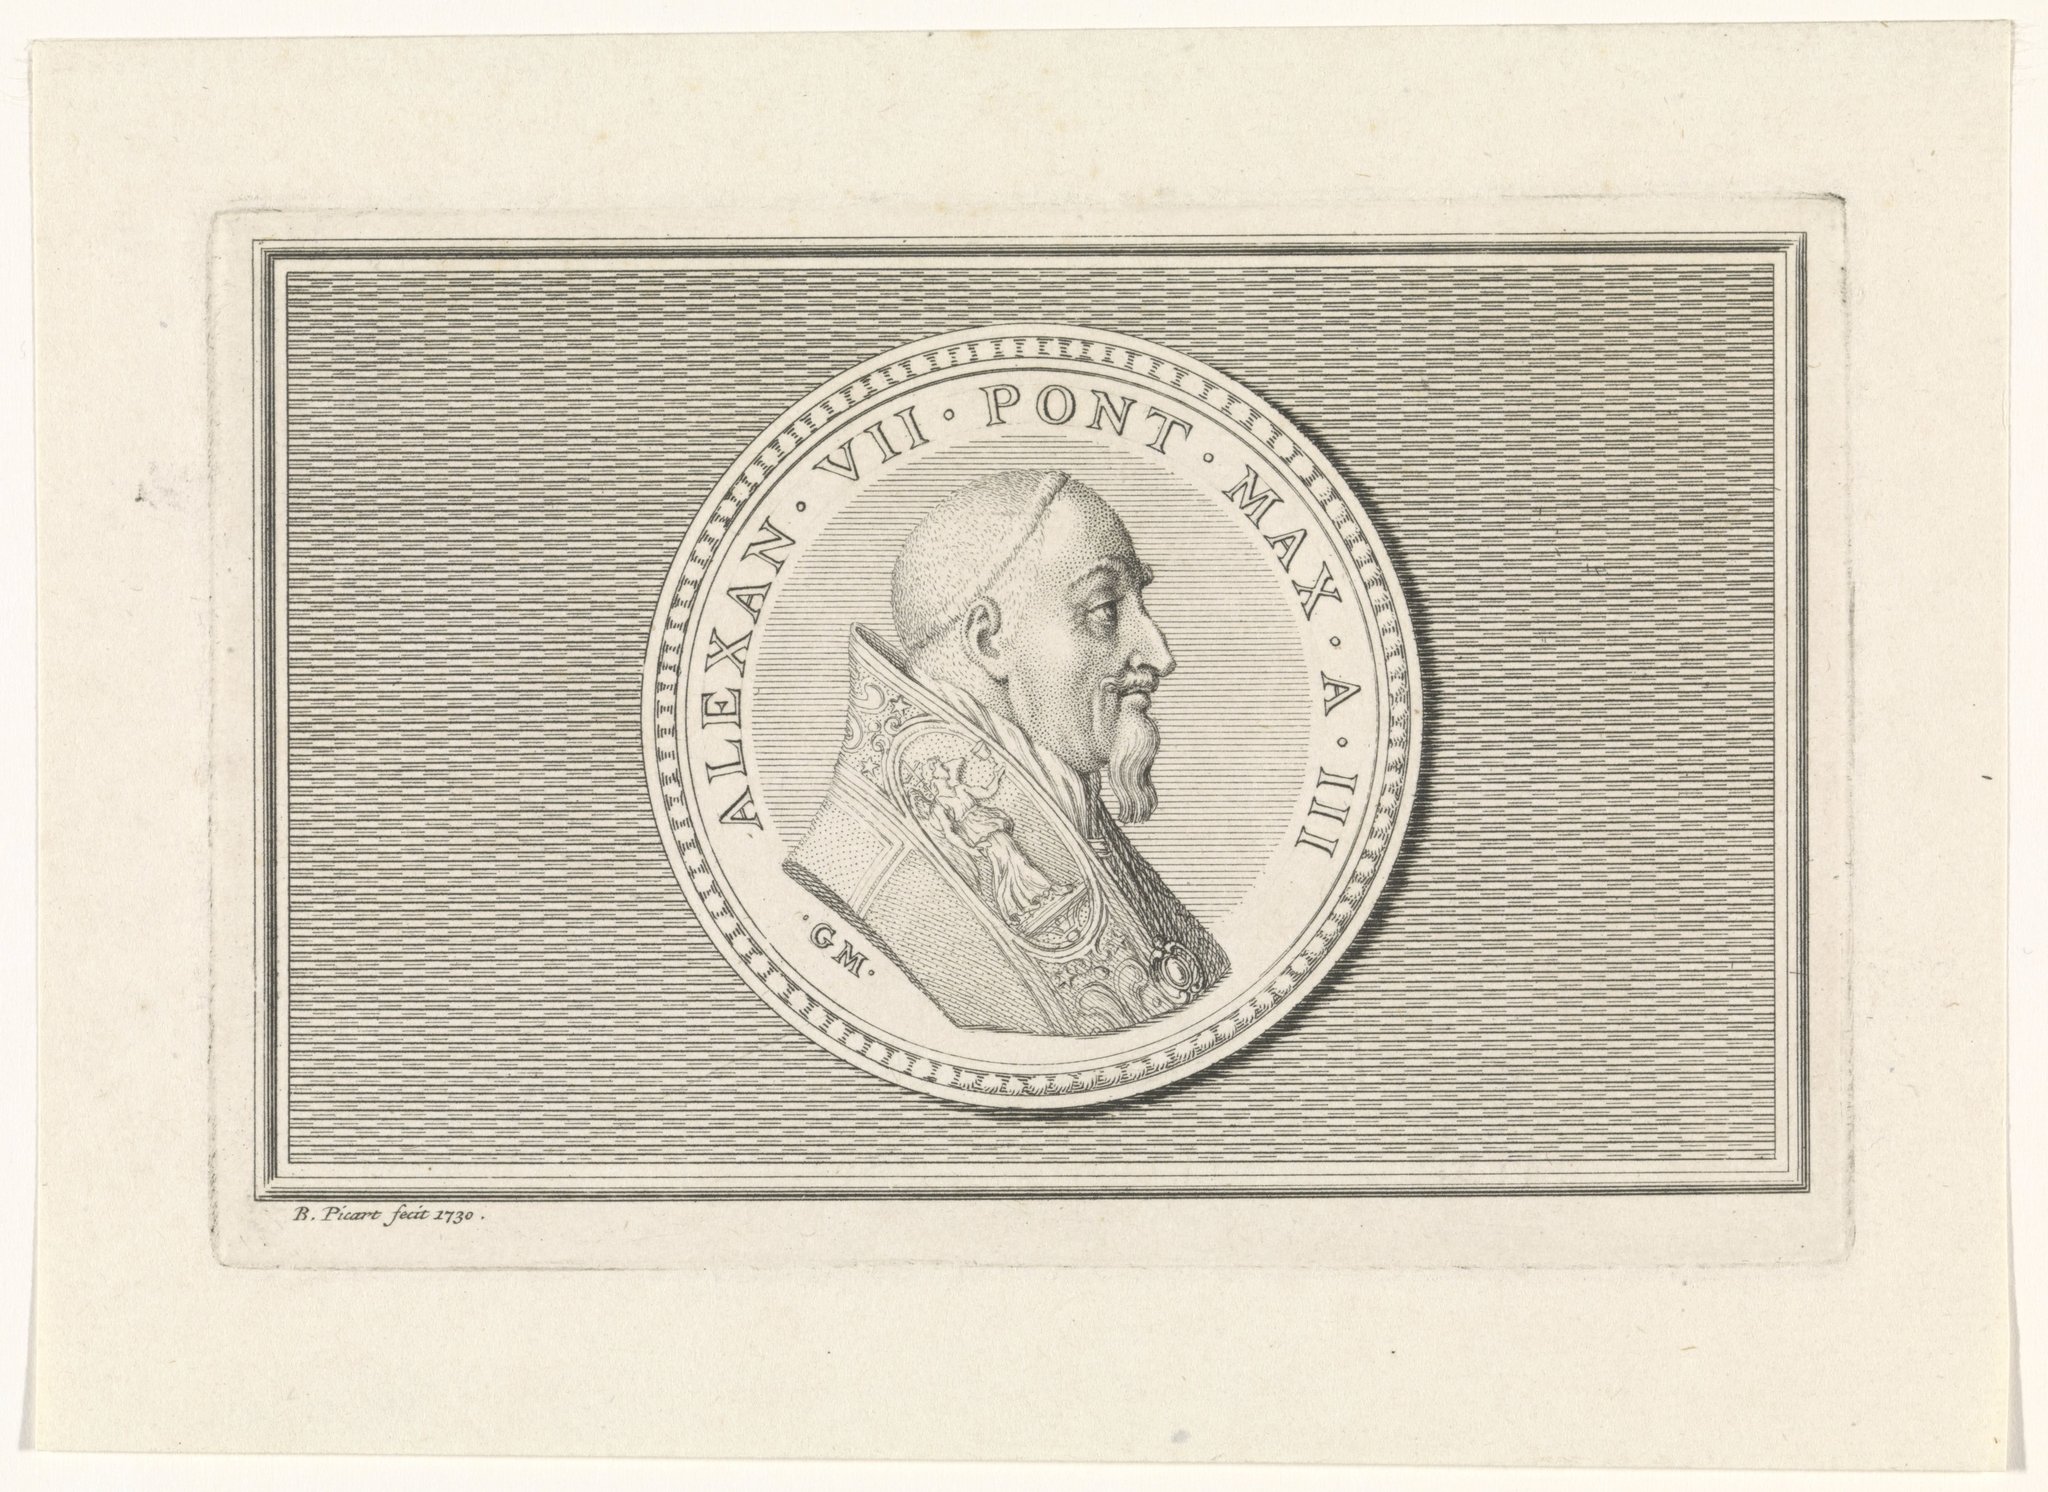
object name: print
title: Penning met het portret van paus Alexander VII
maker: bernard picart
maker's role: draughtsman, print maker, publisher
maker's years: 1673-1733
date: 1730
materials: paper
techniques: engraving, etching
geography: amsterdam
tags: rome, alexander vii, medal (considered as a piece of sculpture, regardless of its specific function)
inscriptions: collector's mark: Lugt 2228